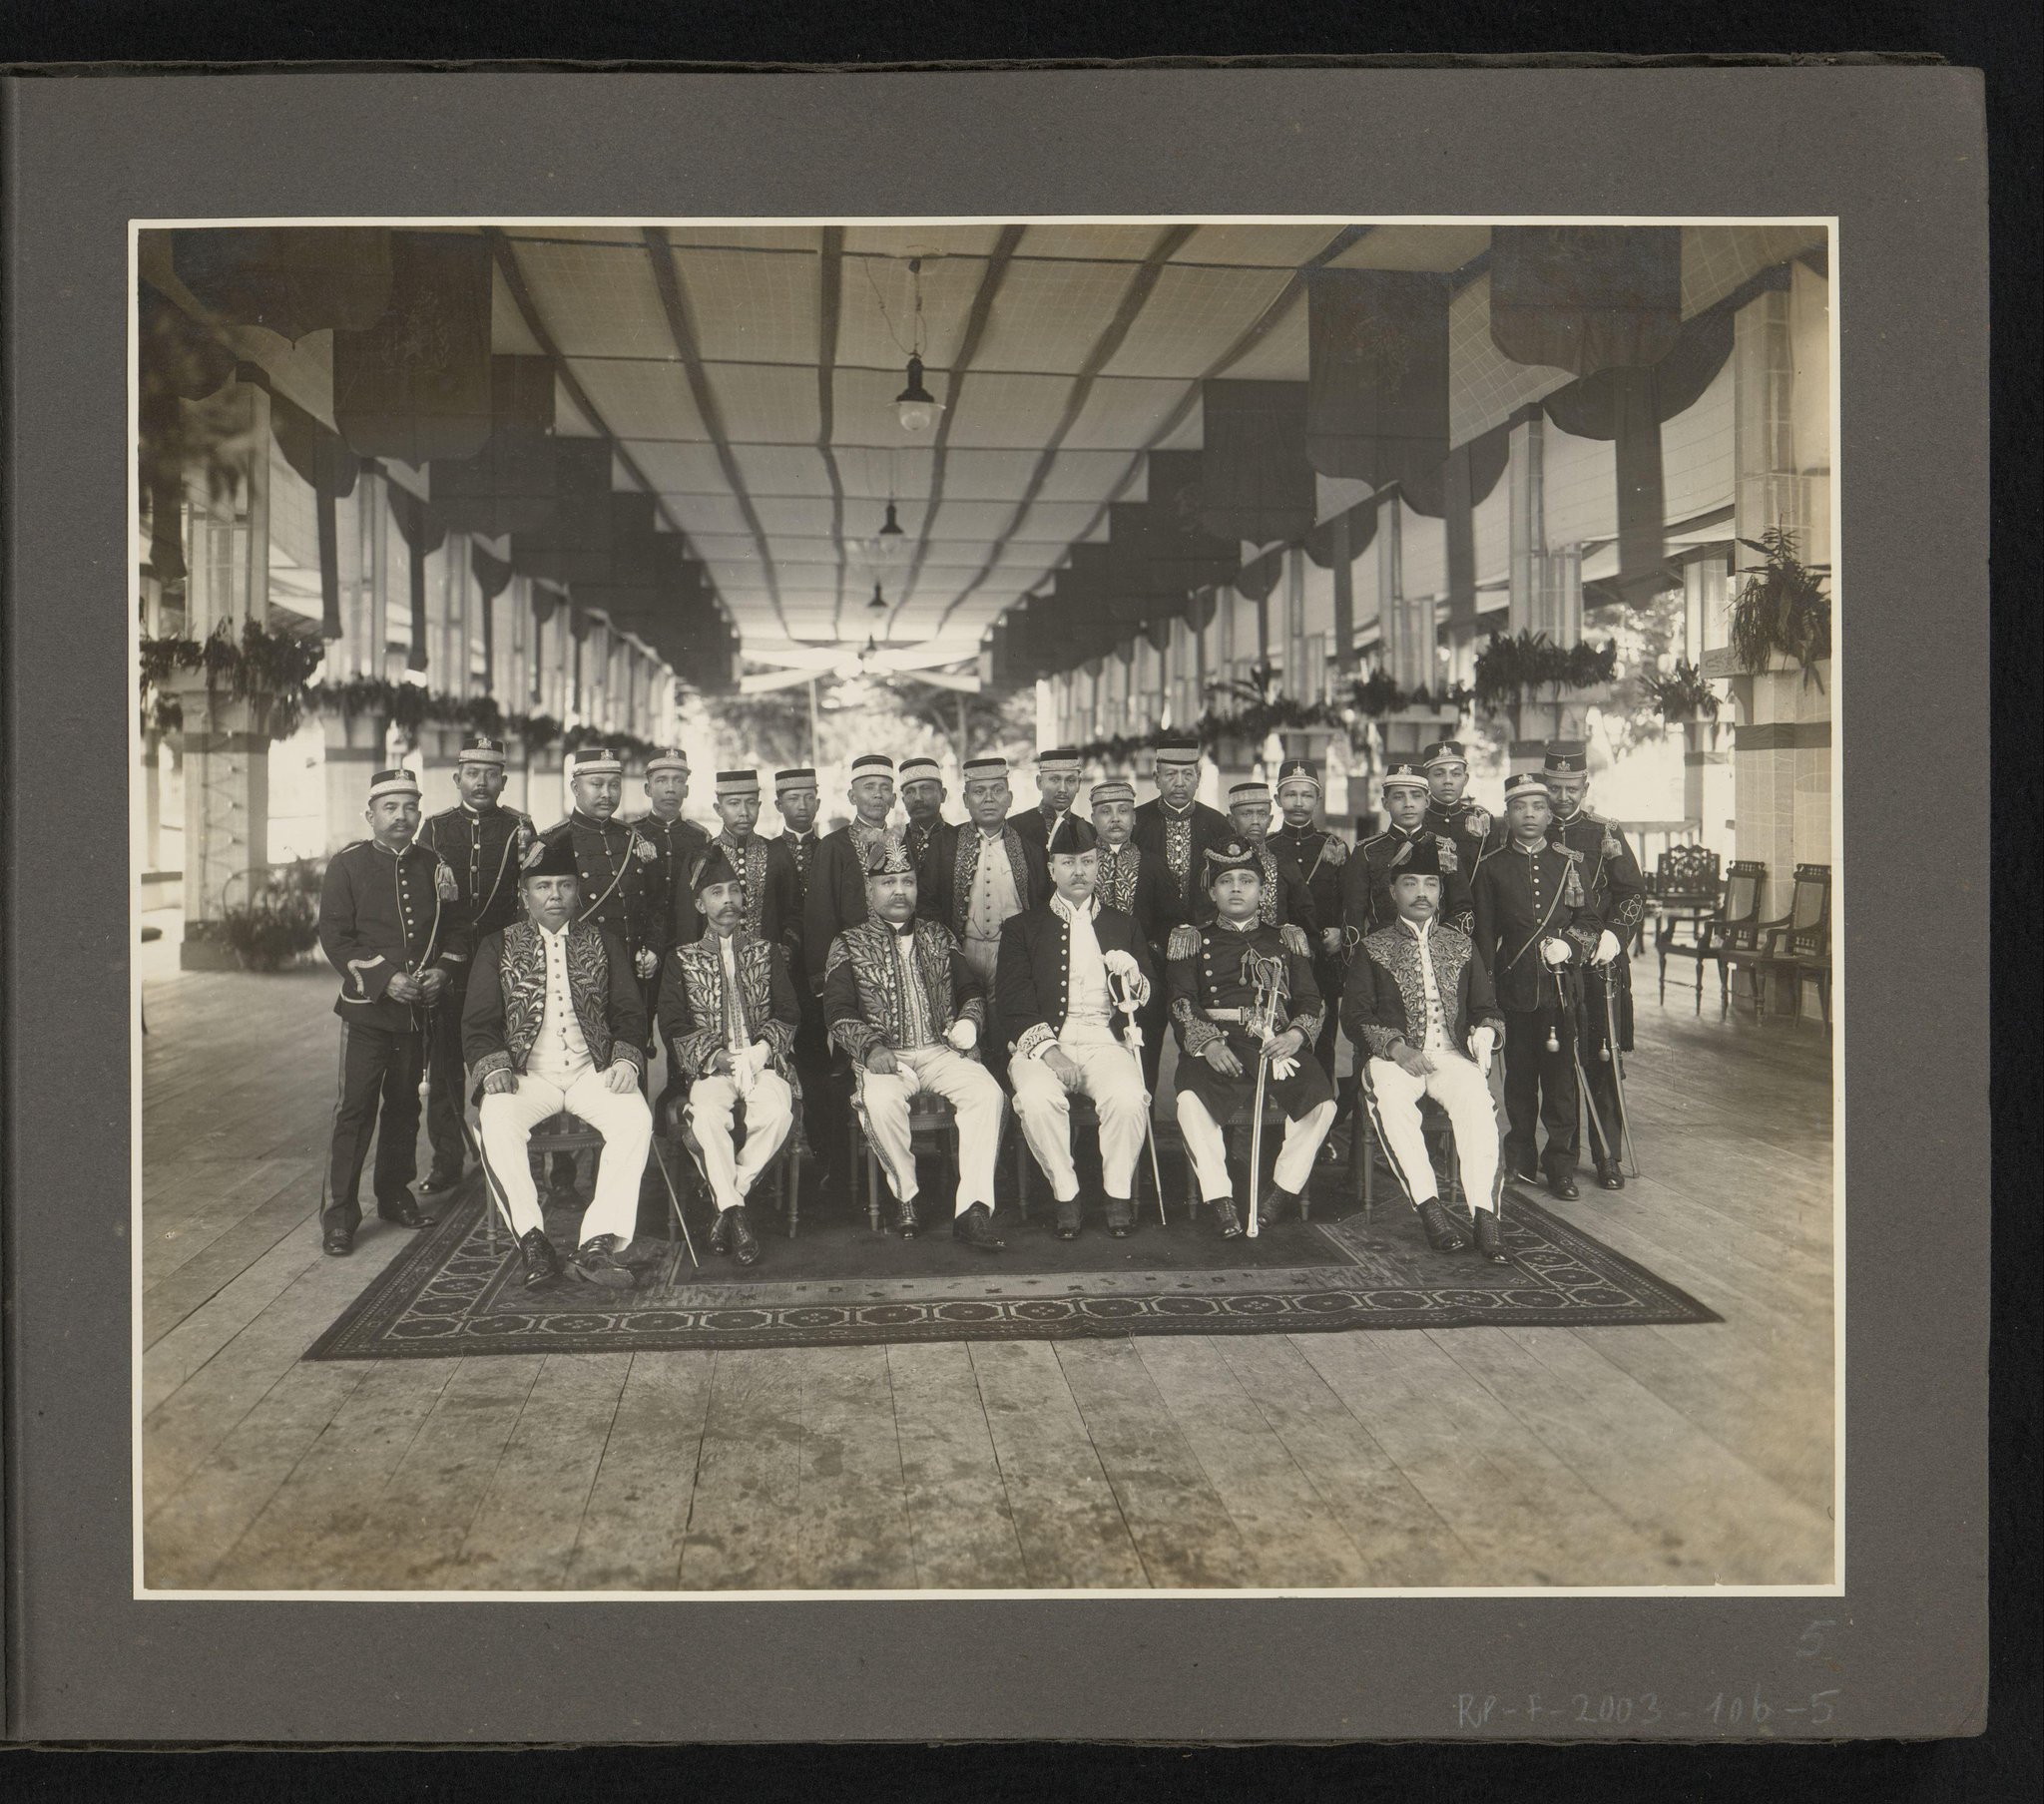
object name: photograph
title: Groepsportret van hooggeplaatsten aan het hof van Langkat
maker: Anonymous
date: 1919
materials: photographic support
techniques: gelatin silver print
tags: adult man, historical persons, ruler, sovereign, sumatra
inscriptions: inscription: ‘Bild 4 erste Reihe Toengkoe Zainal Abidin, Toengkoe Adil. Sultan v. Langkat, Ass. Res. Roos van Raadshoven, Mahmoed, Sohn des Sultans, Sjaksa v. Tdj. Poera (...)’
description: Eerste rij: Toengkoe Zainal Abidin van Pangkalan Brandan, Toenkoe Adil van Bindjei, Sultan van Langkat, Assistent Resident Roos van Raadshoven, Mahmoed, zoon van sultan en Djaksa (procureur generaal) van Tanjongpoera, tweede rij: Dato van Besitan en onbekende Dato's. Deze foto maakt deel uit van een album.